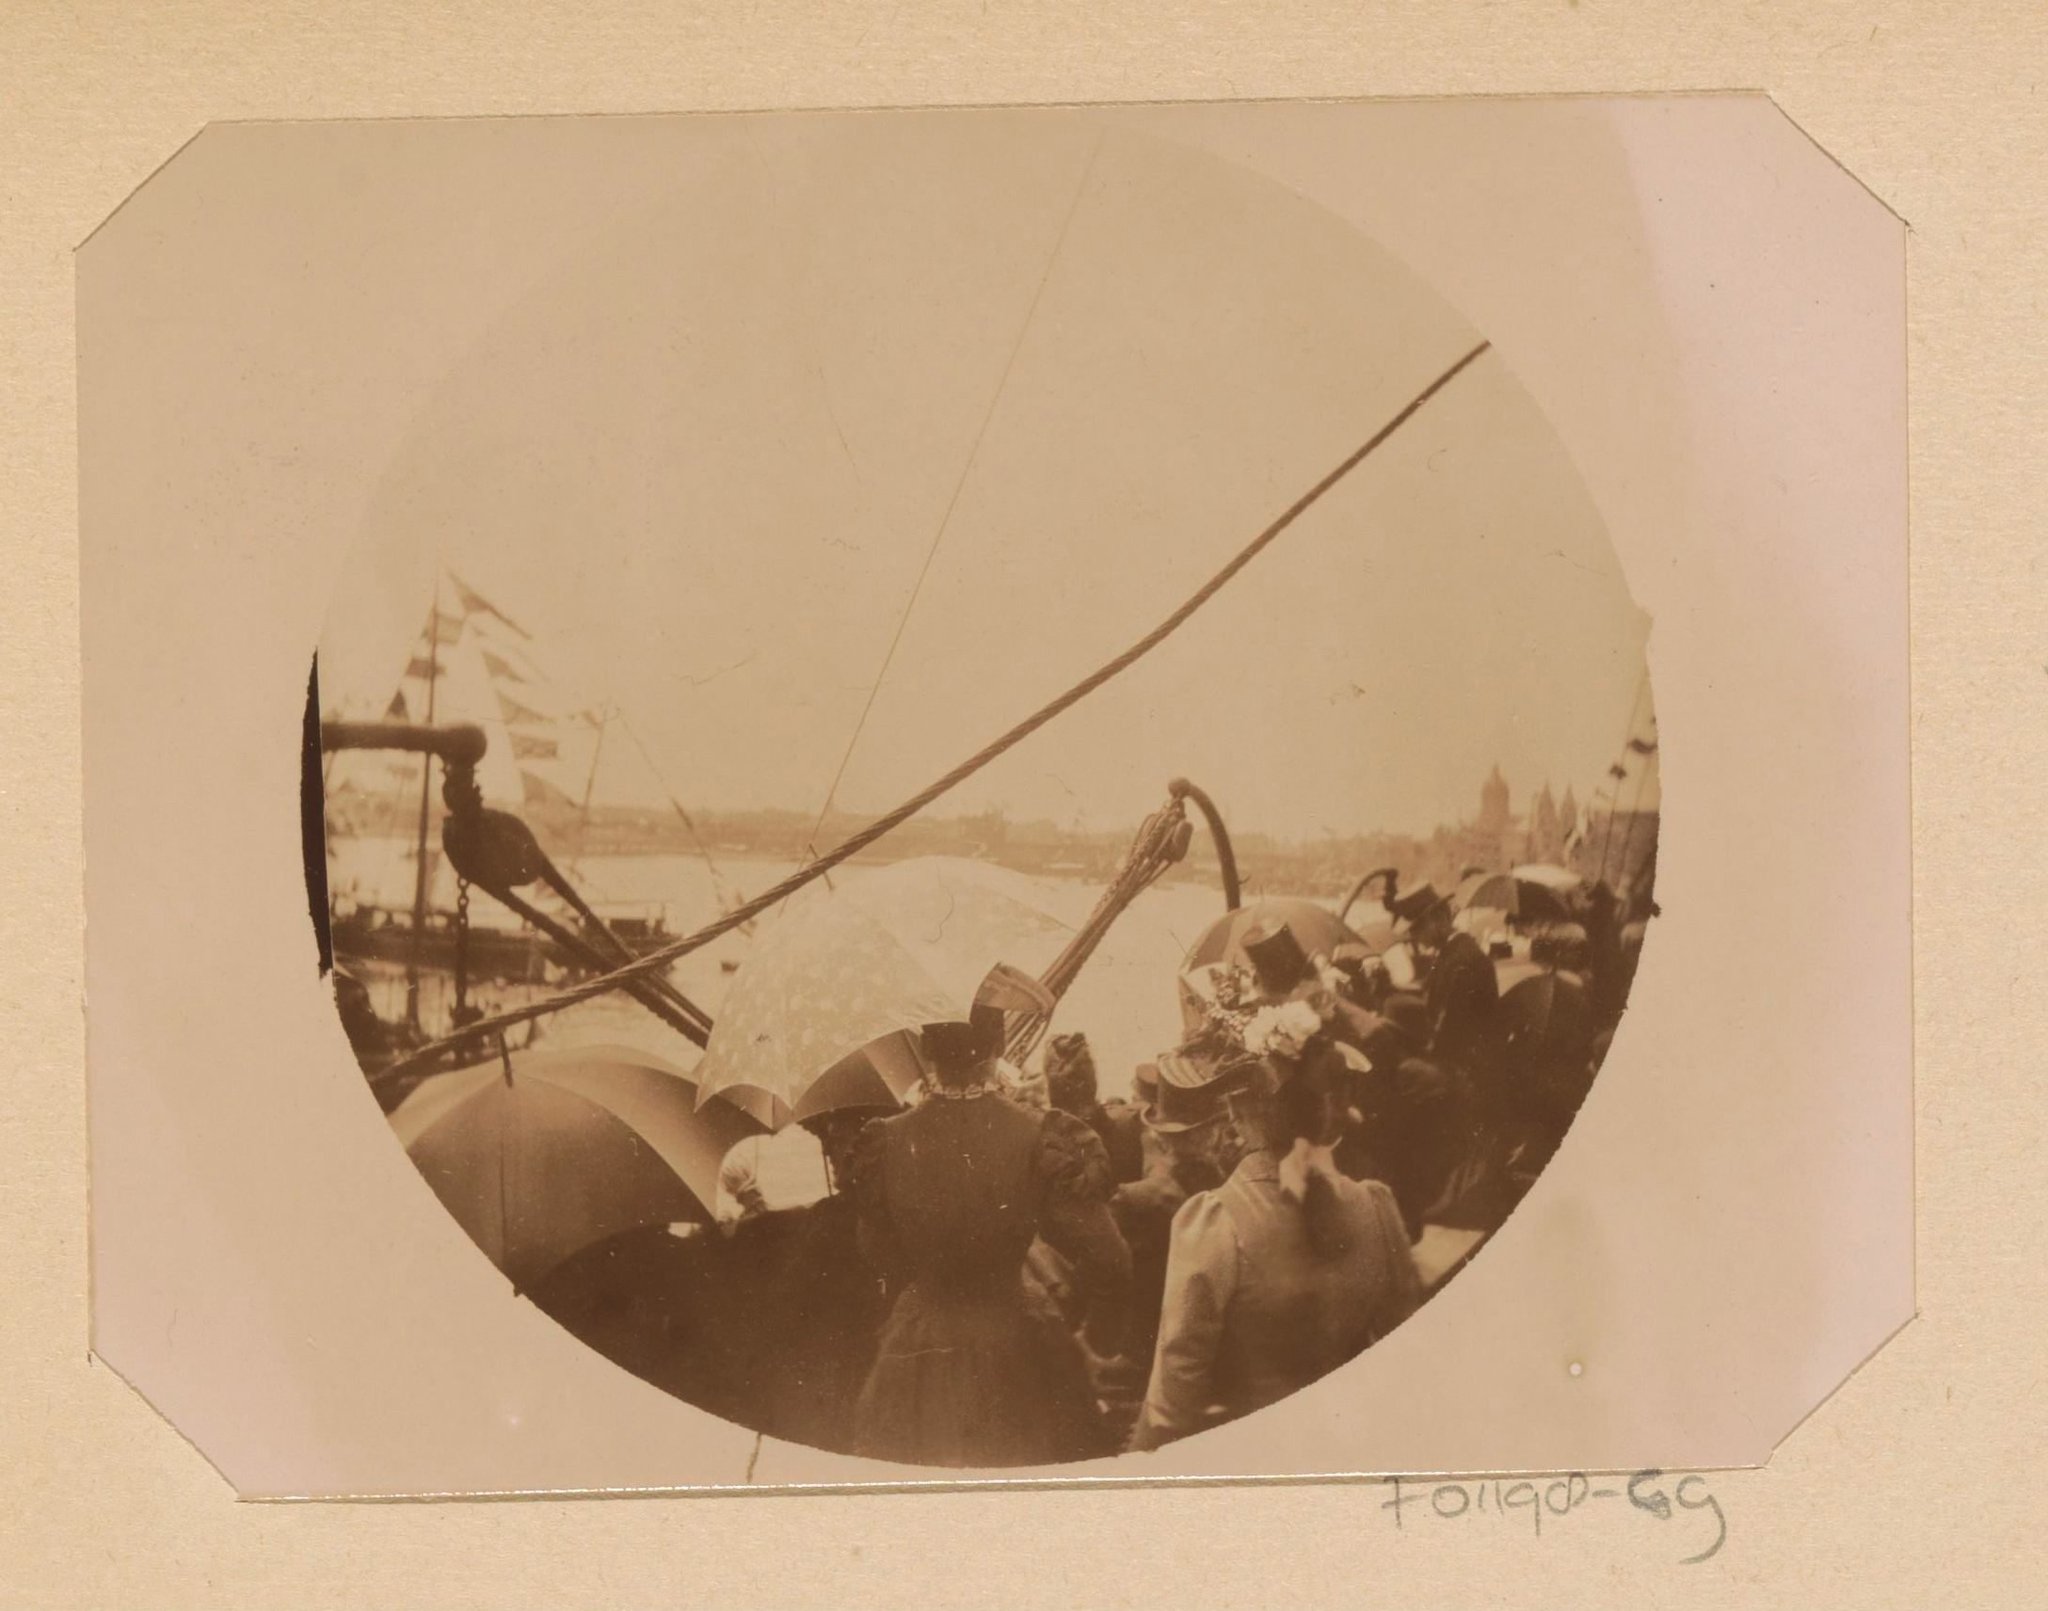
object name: photograph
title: Keizersfeesten 1891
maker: johanna margaretha piek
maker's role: fotograaf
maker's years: 1870-1947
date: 1891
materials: paper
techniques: gelatin silver print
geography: amsterdam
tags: harbour, imperial celebrations 1891